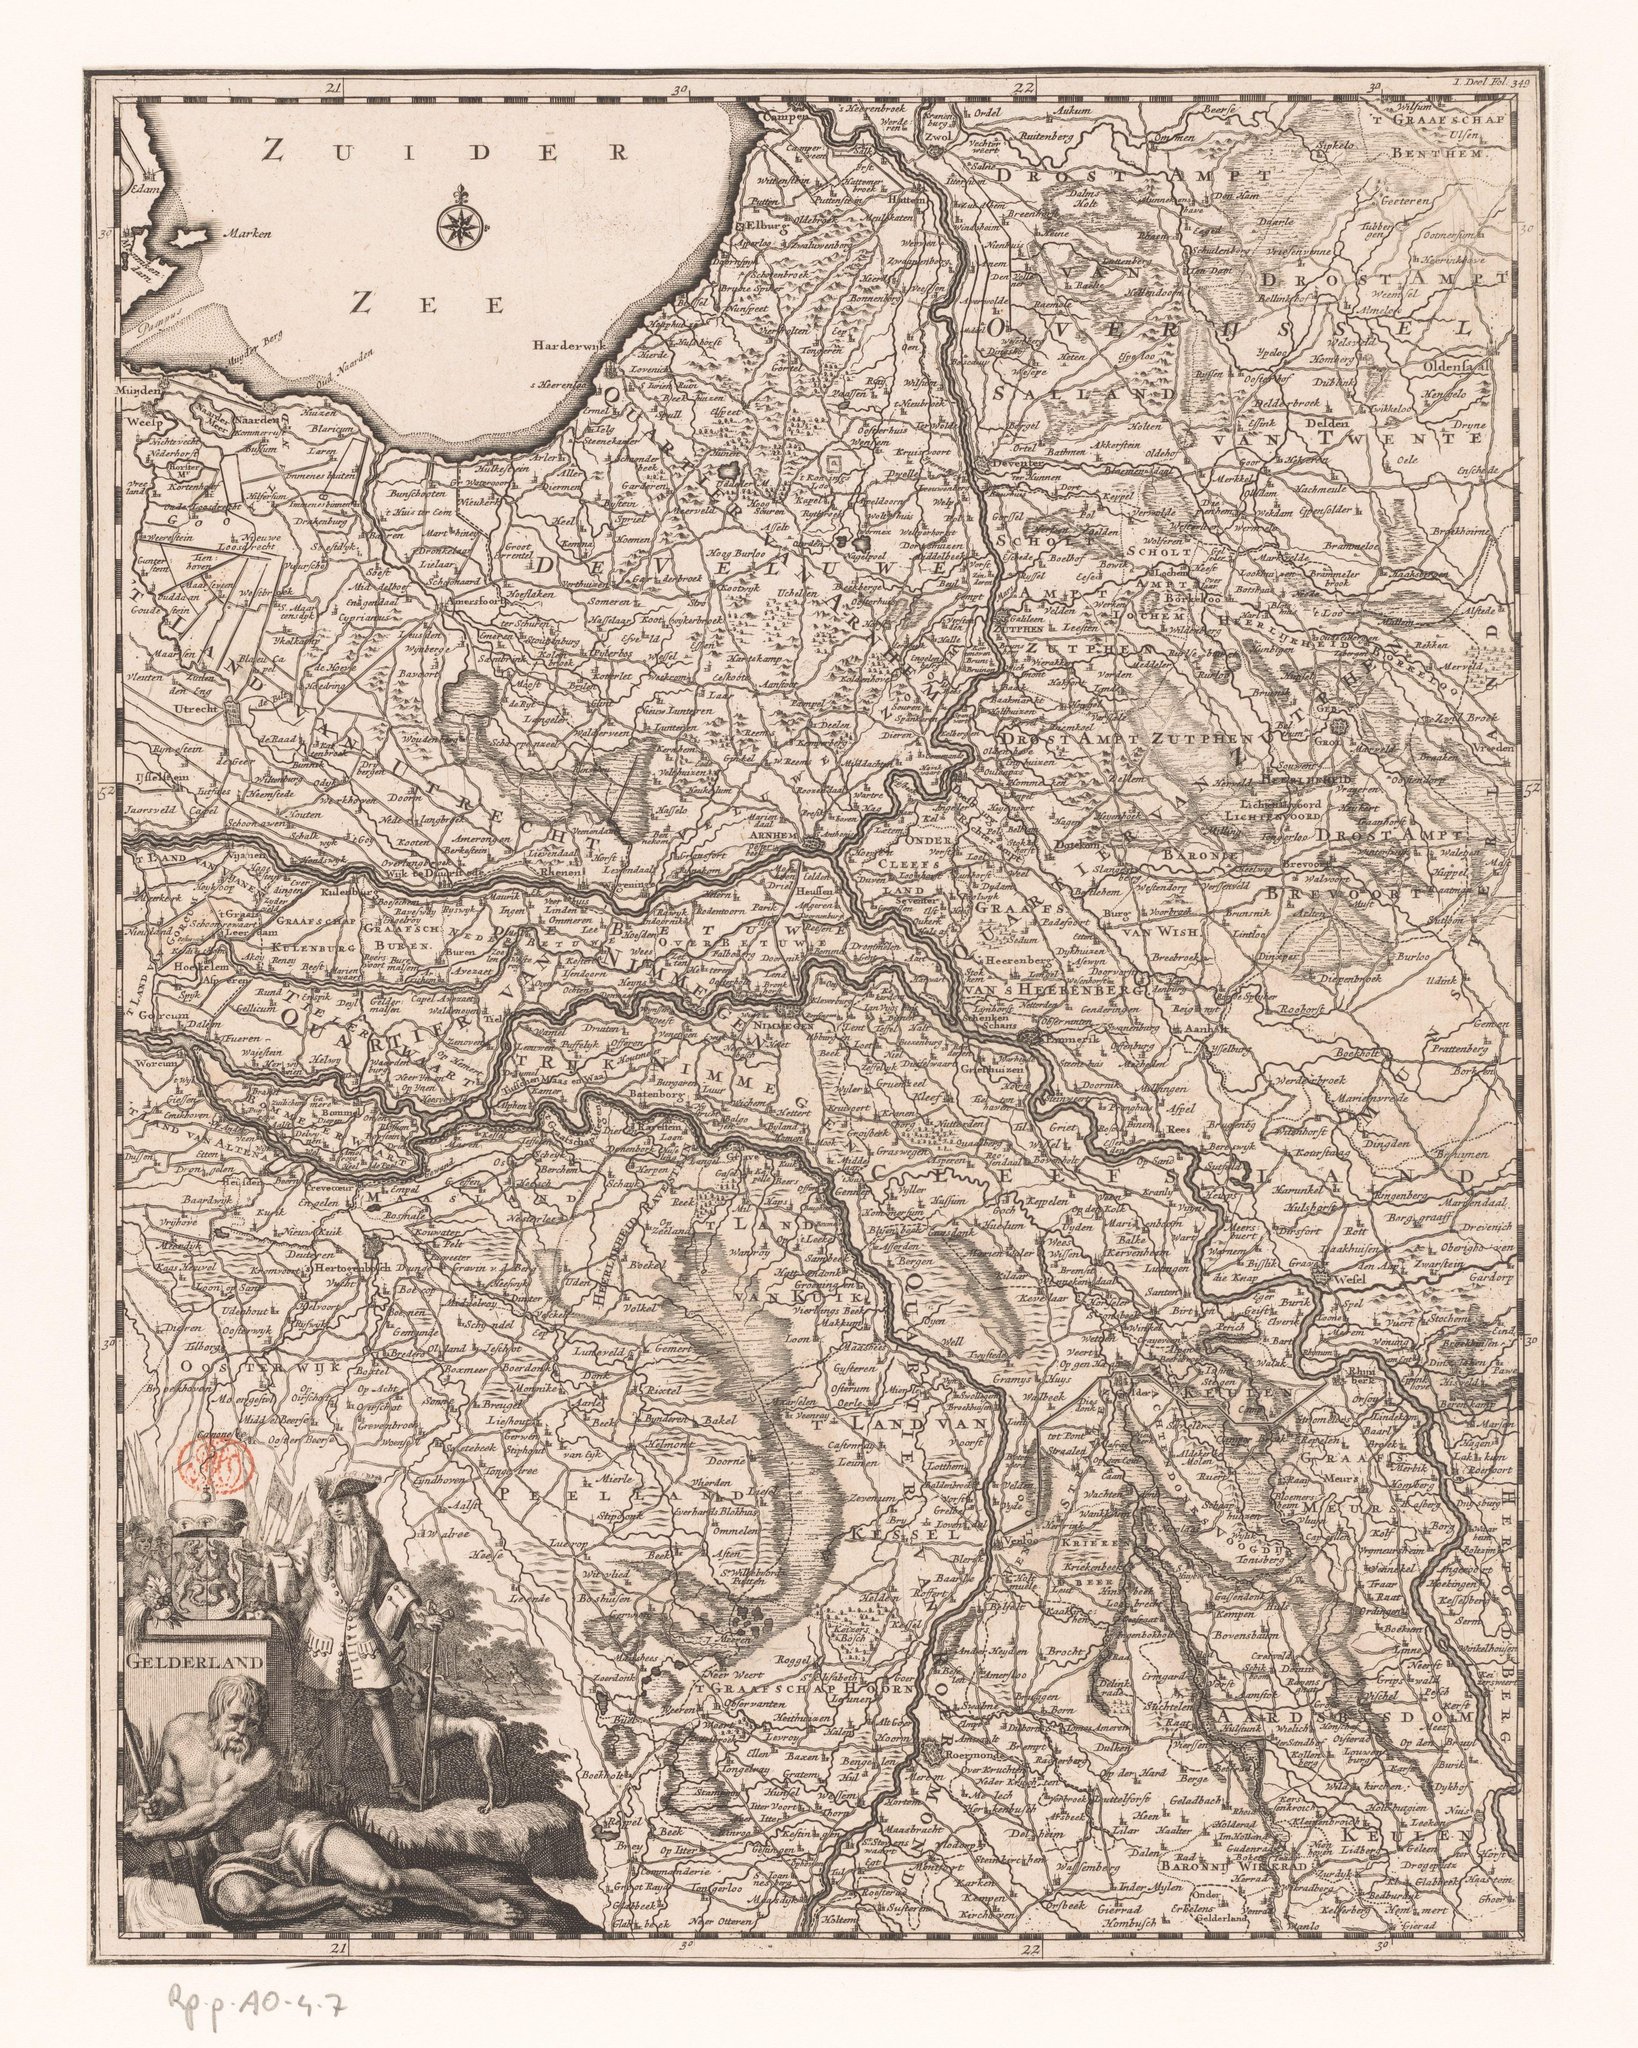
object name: print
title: Kaart van Gelderland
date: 1725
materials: paper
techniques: engraving, etching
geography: leeuwarden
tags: maps of separate countries or regions, coat of arms (as symbol of the state, etc.) (+ province; provincial)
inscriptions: collector's mark: Lugt 195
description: Linksonder de titelcartouche, met bovenin het wapen van Gelre. Bij de cartouche een riviergod en een heer met windhond. Rechtsboven gemerkt: 1. Deel Fol. 349. De kaart is voorzien van een gradenverdeling langs de randen.